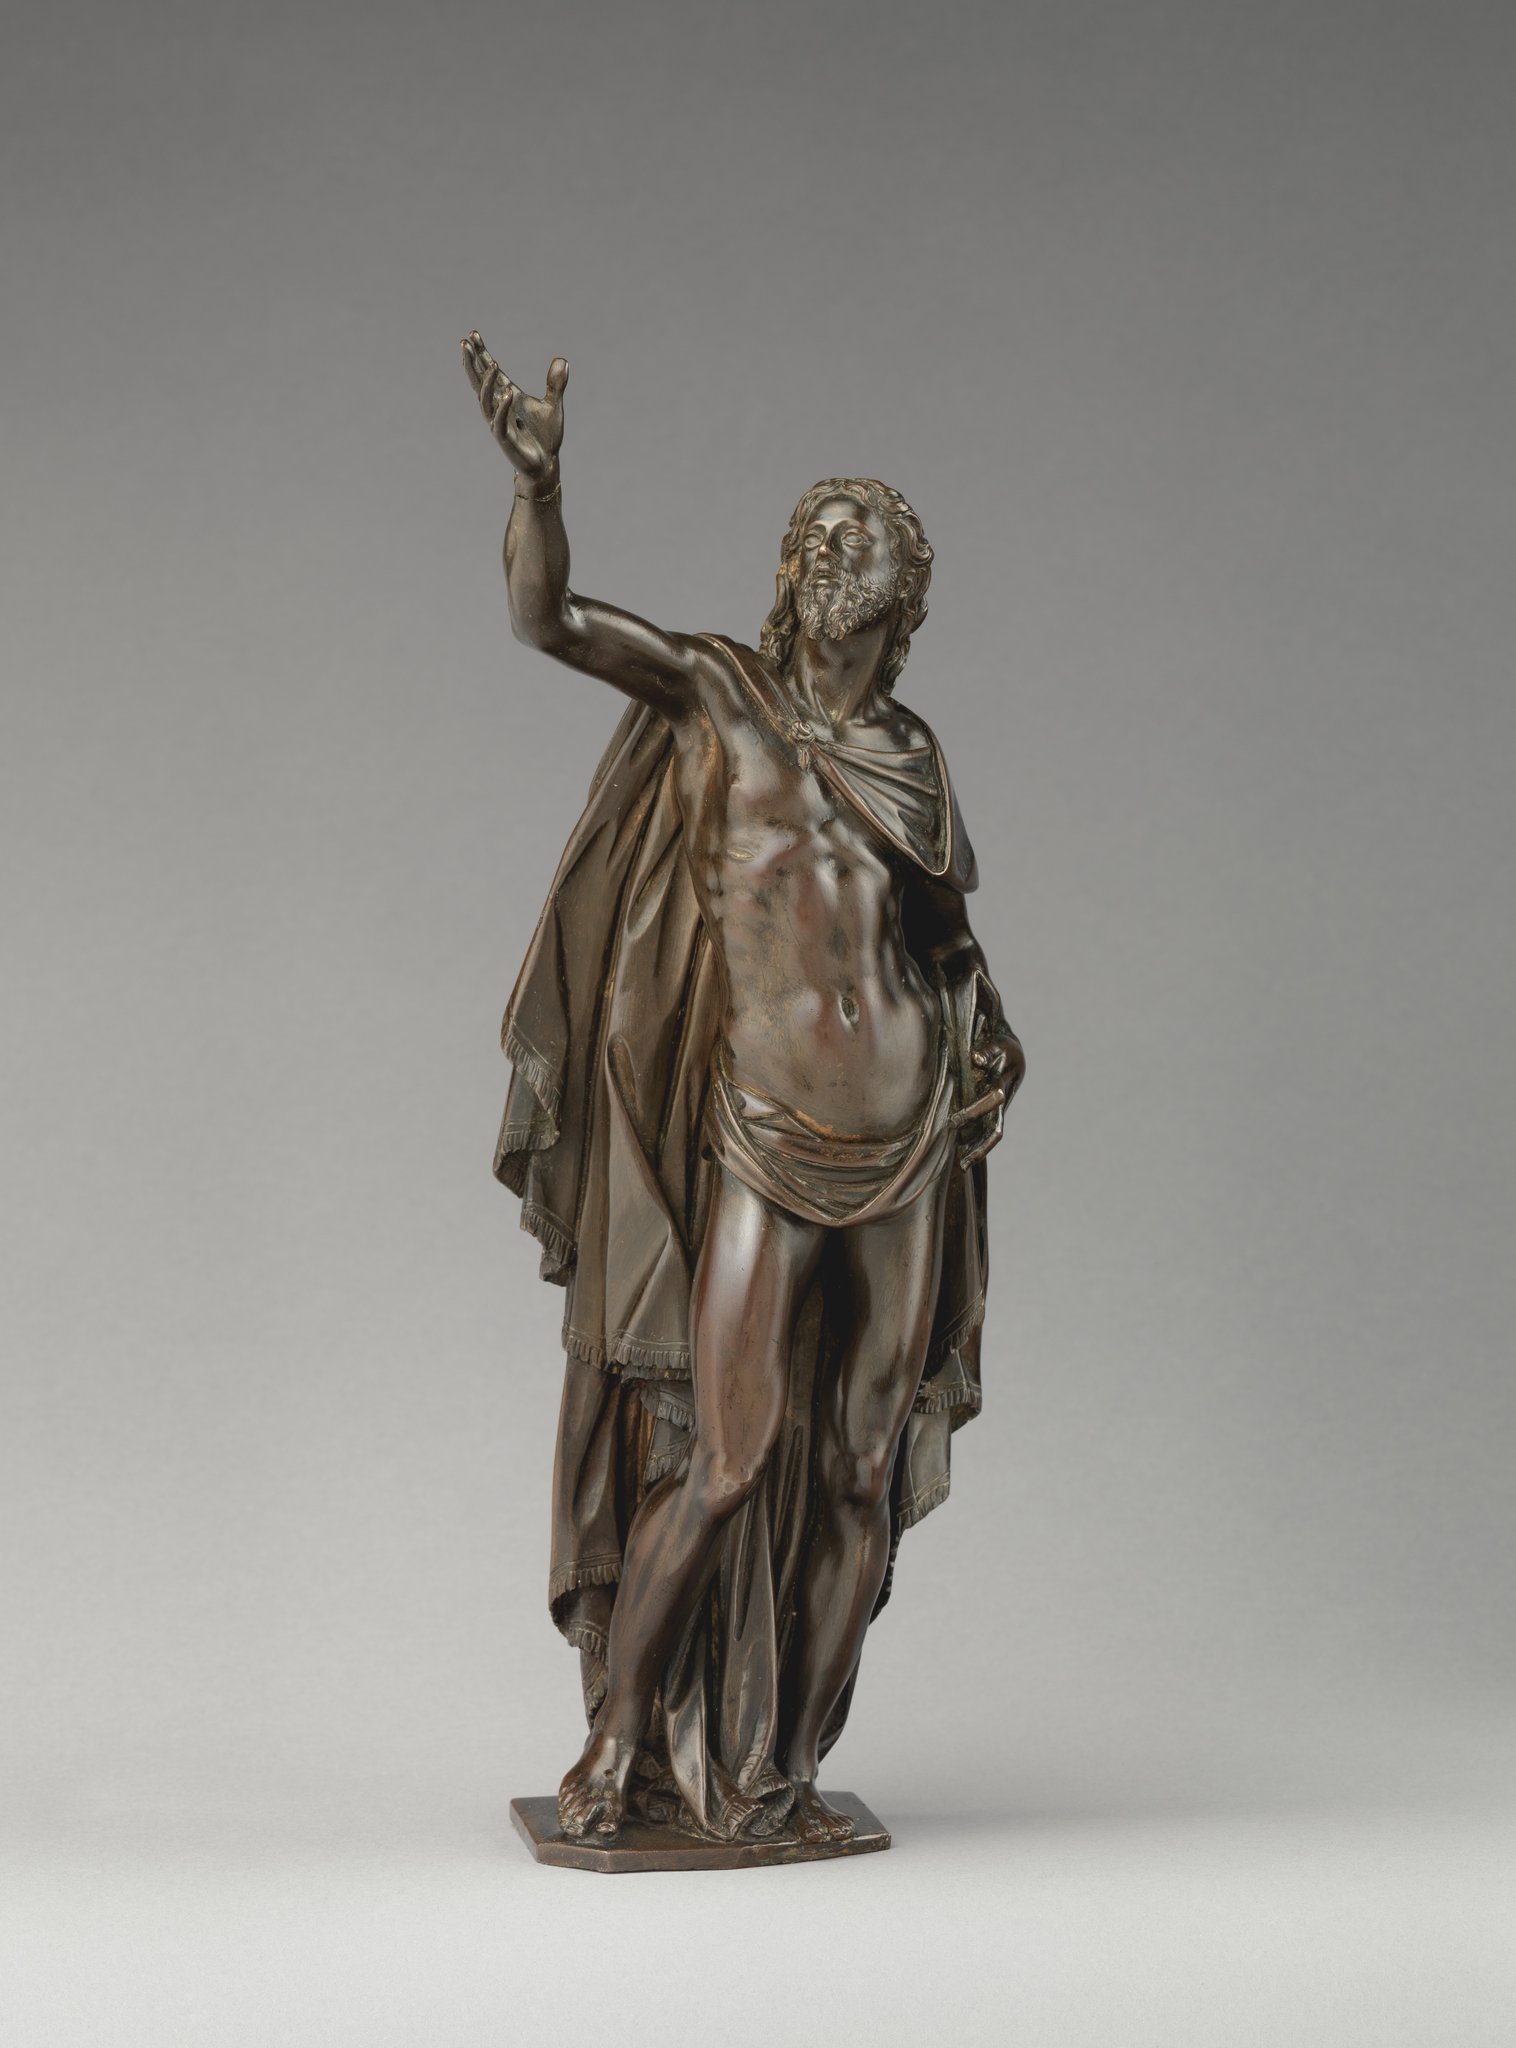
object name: statuette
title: The risen Christ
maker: antonio susini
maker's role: artist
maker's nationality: italian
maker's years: 1558-1624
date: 1596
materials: bronze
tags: christ